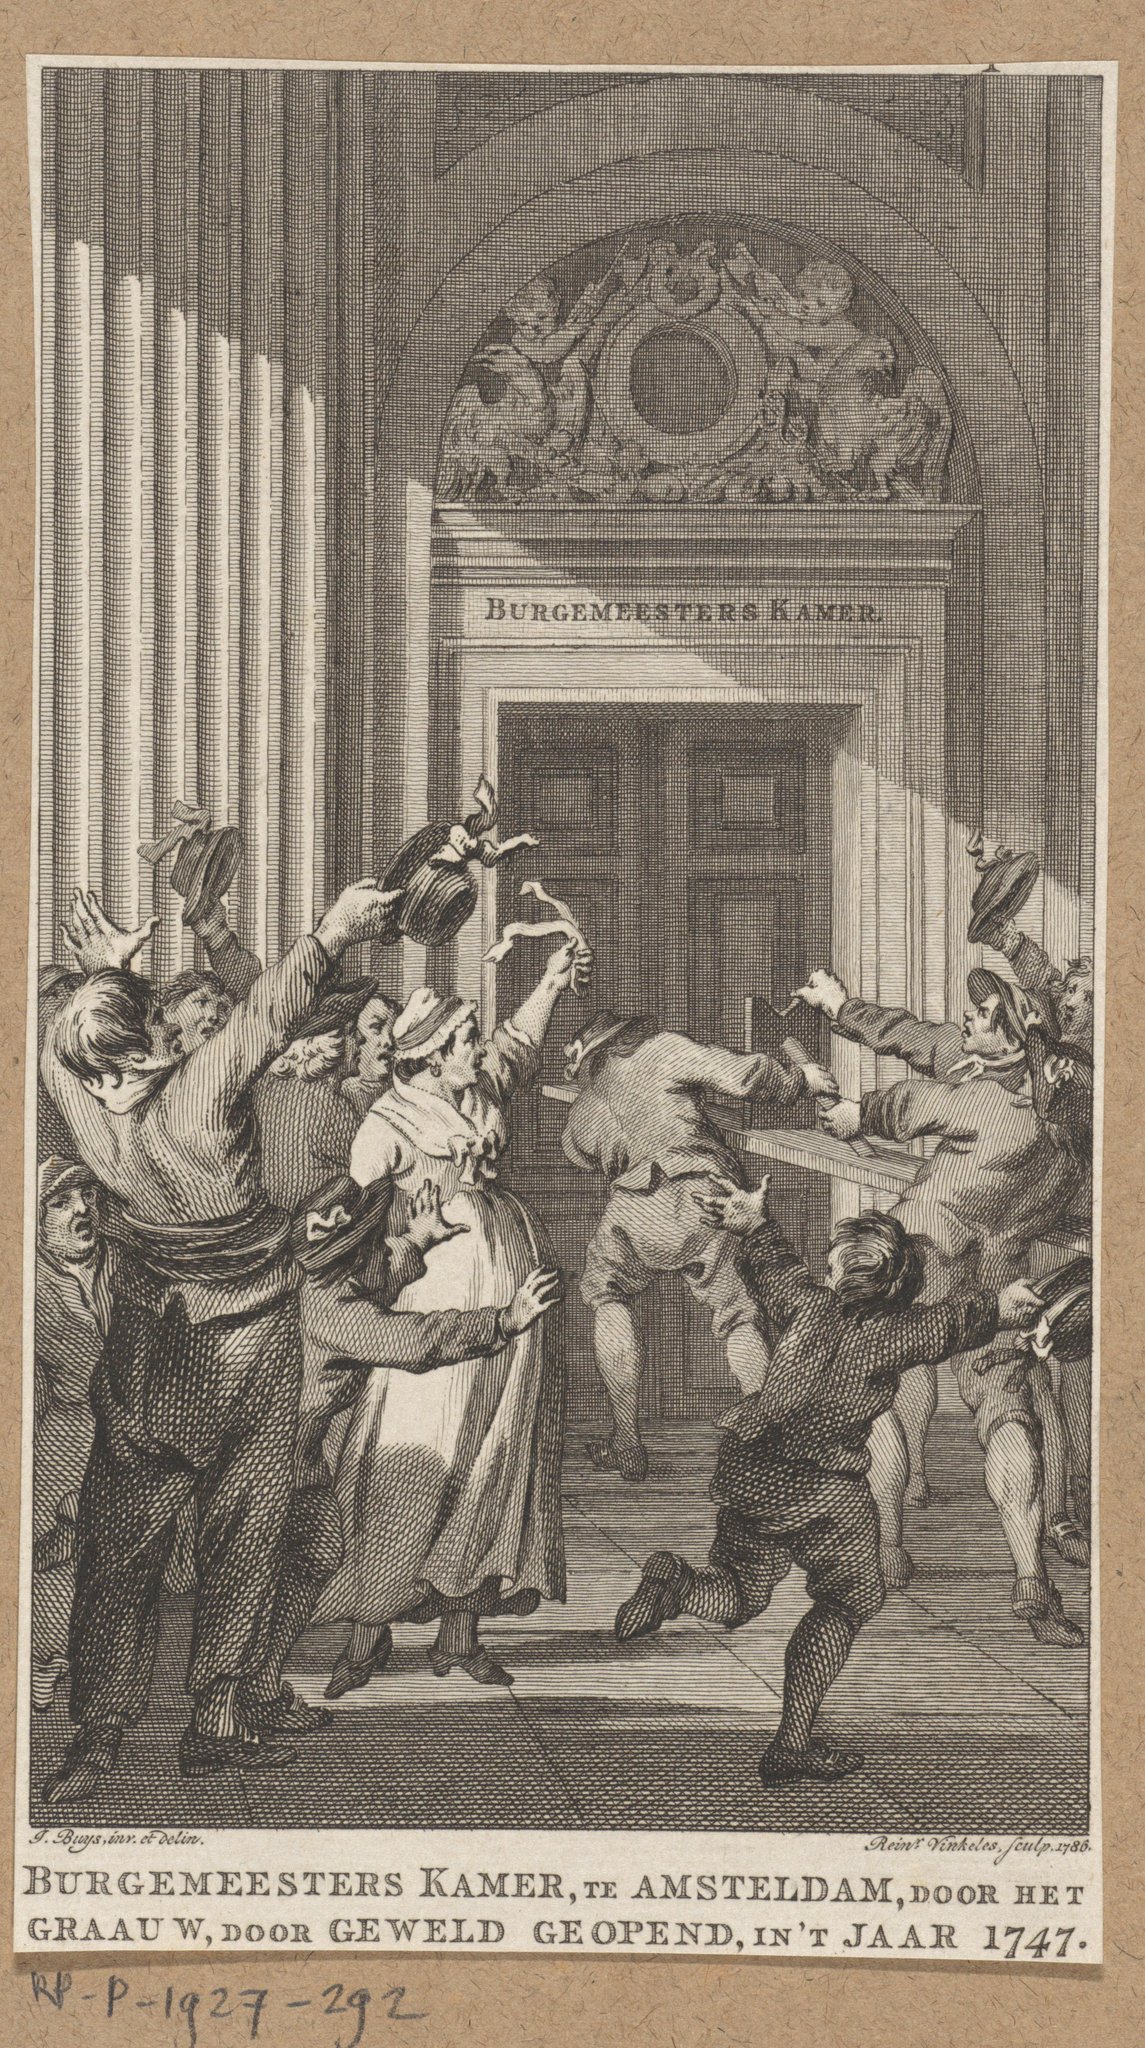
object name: history print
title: Burgemeesters Kamer, te Amsterdam, door het Graauw, door Geweld Geopend, in 't Jaar 1747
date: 1786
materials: paper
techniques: engraving, etching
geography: amsterdam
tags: plundering ~ riot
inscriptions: date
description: Gebruikt als illustratie in: Kok, Jacobus. Vaderlandsch Woordenboek. Amsterdam: Johannes Allart, 1785-1799, 35 delen, dl. 2, pl. 4.